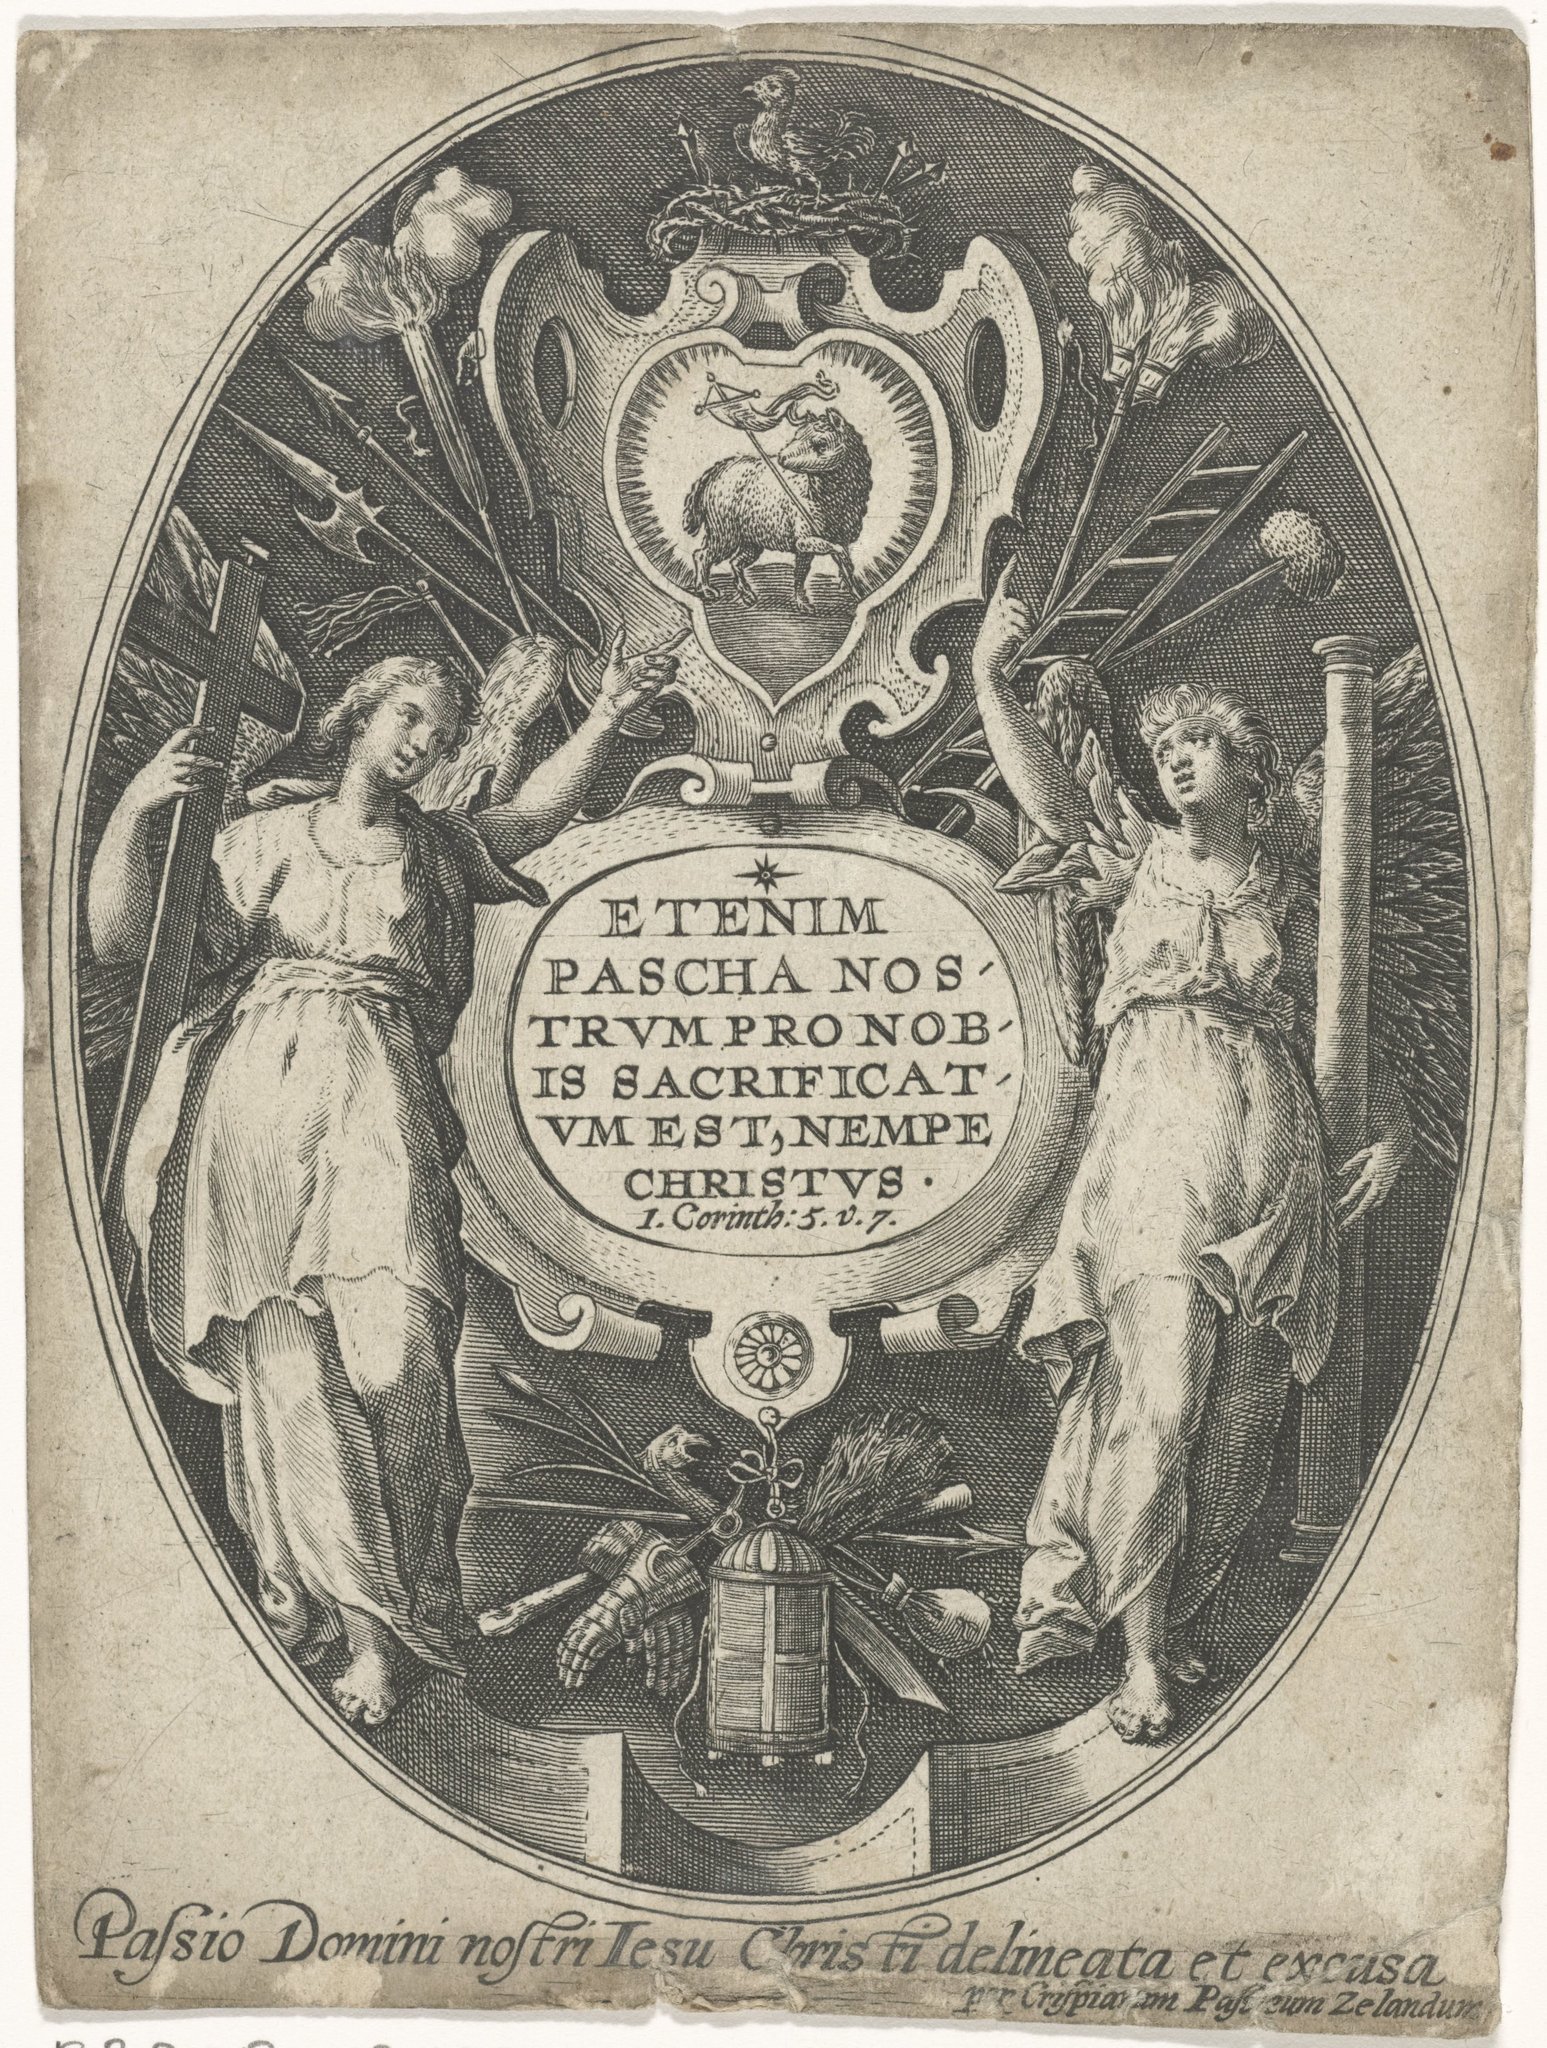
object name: titelprent, frontispice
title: Passio Domini nostri Jesu Christi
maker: crispijn van de passe (i)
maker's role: draughtsman, print maker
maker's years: 1564-1637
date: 1600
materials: paper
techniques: engraving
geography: cologne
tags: passion of christ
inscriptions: collector's mark: Lugt 2228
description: Twee engelen wijzen naar een cartouche met het Lam Gods. Ze flankeren een cartouche met een Bijbelcitaat in het Latijn, waaromheen de passiewerktuigen. De voorstelling is gevat in een ovale omlijsting. In de marge de serietitel in het Latijn. Titelprent voor een serie met de passie van Christus.